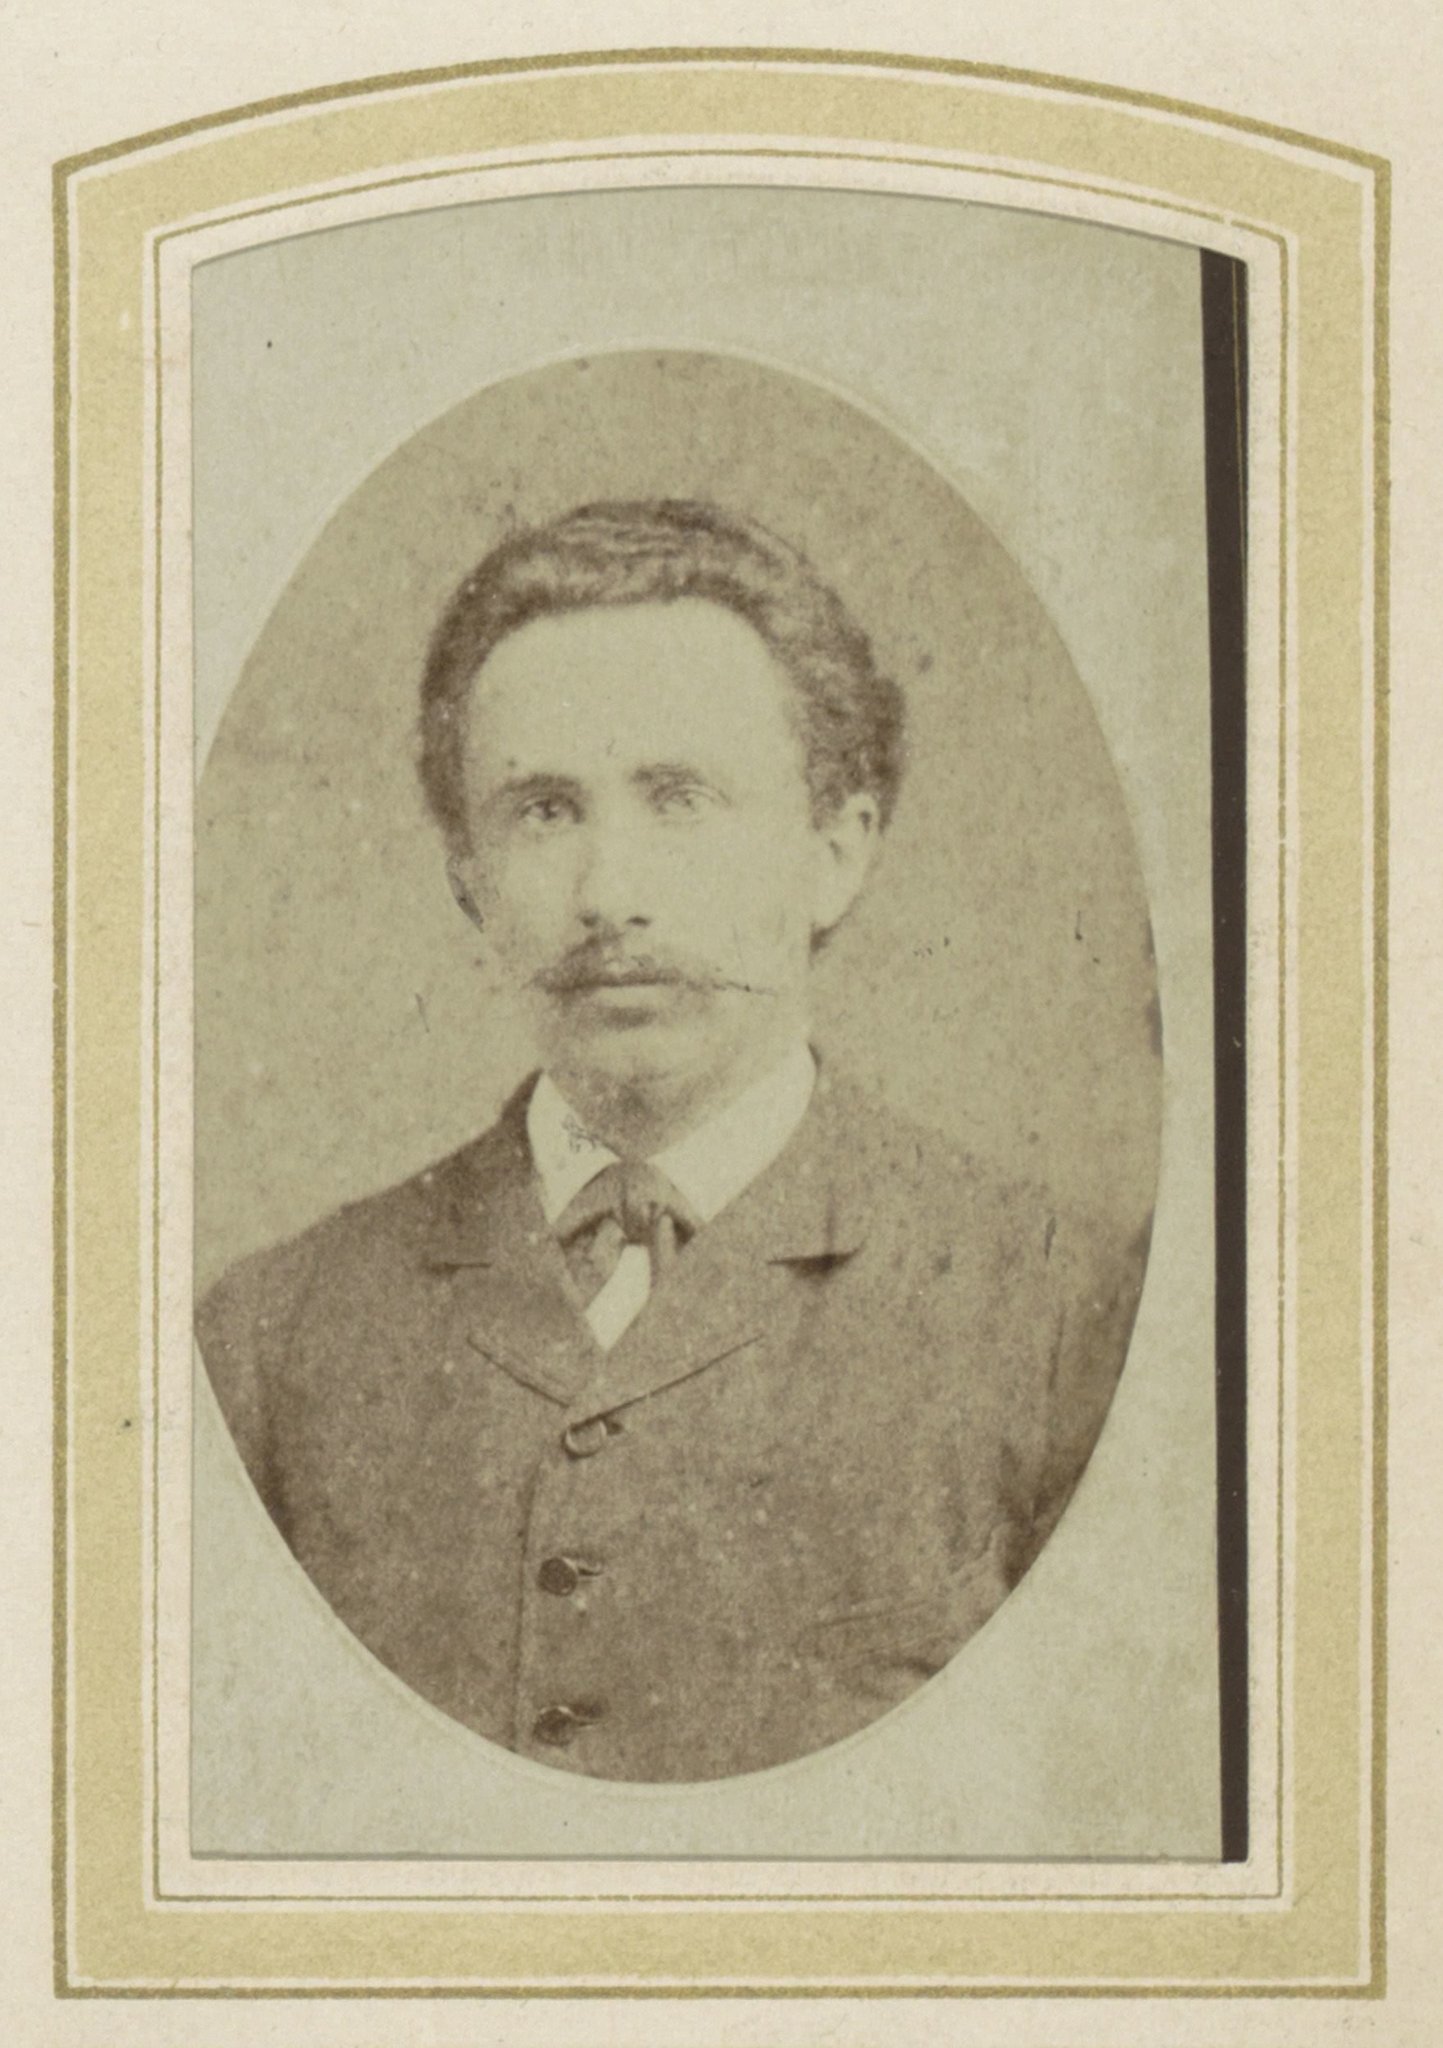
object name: photograph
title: Portret van een man met een snor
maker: lambertus johannes bruna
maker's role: fotograaf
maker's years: 1822-1906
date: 1863-1900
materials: cardboard, paper, photographic support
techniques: albumen print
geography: enschede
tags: moustache, historical persons, neck-gear ~ clothing, clothing for the upper part of the body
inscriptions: address: ‘Enschede’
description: Onderdeel van Fotoalbum van een Nederlandse familie met 168 cartes-de-visite en kabinetfoto's.